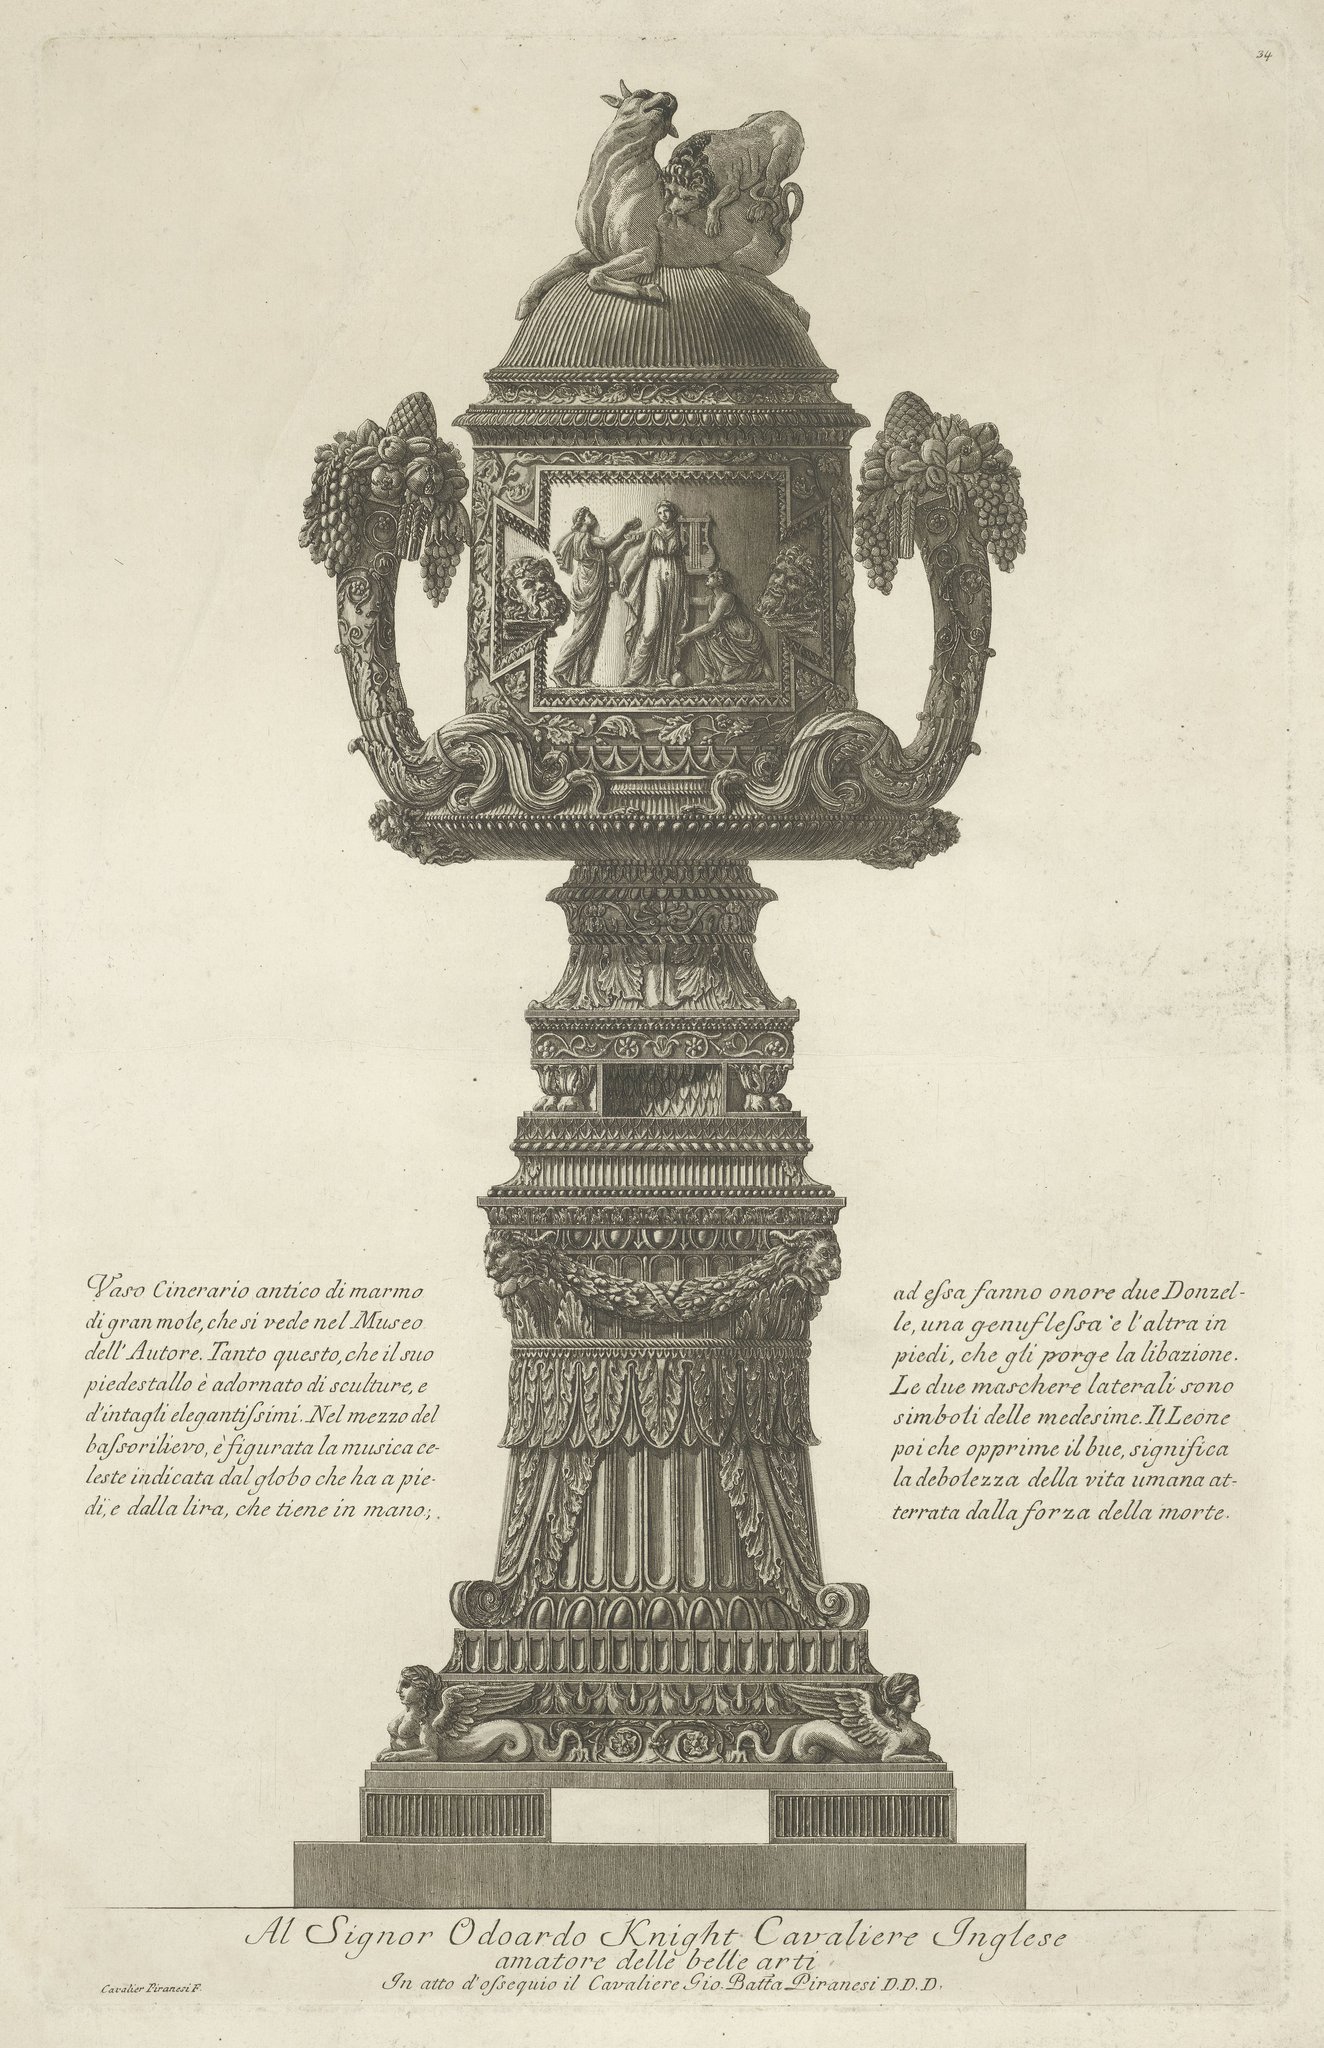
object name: print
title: Asvaas op voetstuk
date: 1778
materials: paper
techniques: etching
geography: rome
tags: urn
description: De 'Vasi'-reeks telt 110 prenten, verspreid over twee volumes met elk een eigen titelprent. Piranesi werd voor deze reeks geholpen door verschillende assistenten uit zijn werkplaats, waaronder zijn zoon Francesco die ook nog eens 8 platen toevoegde aan de reeks in 1779-1780.